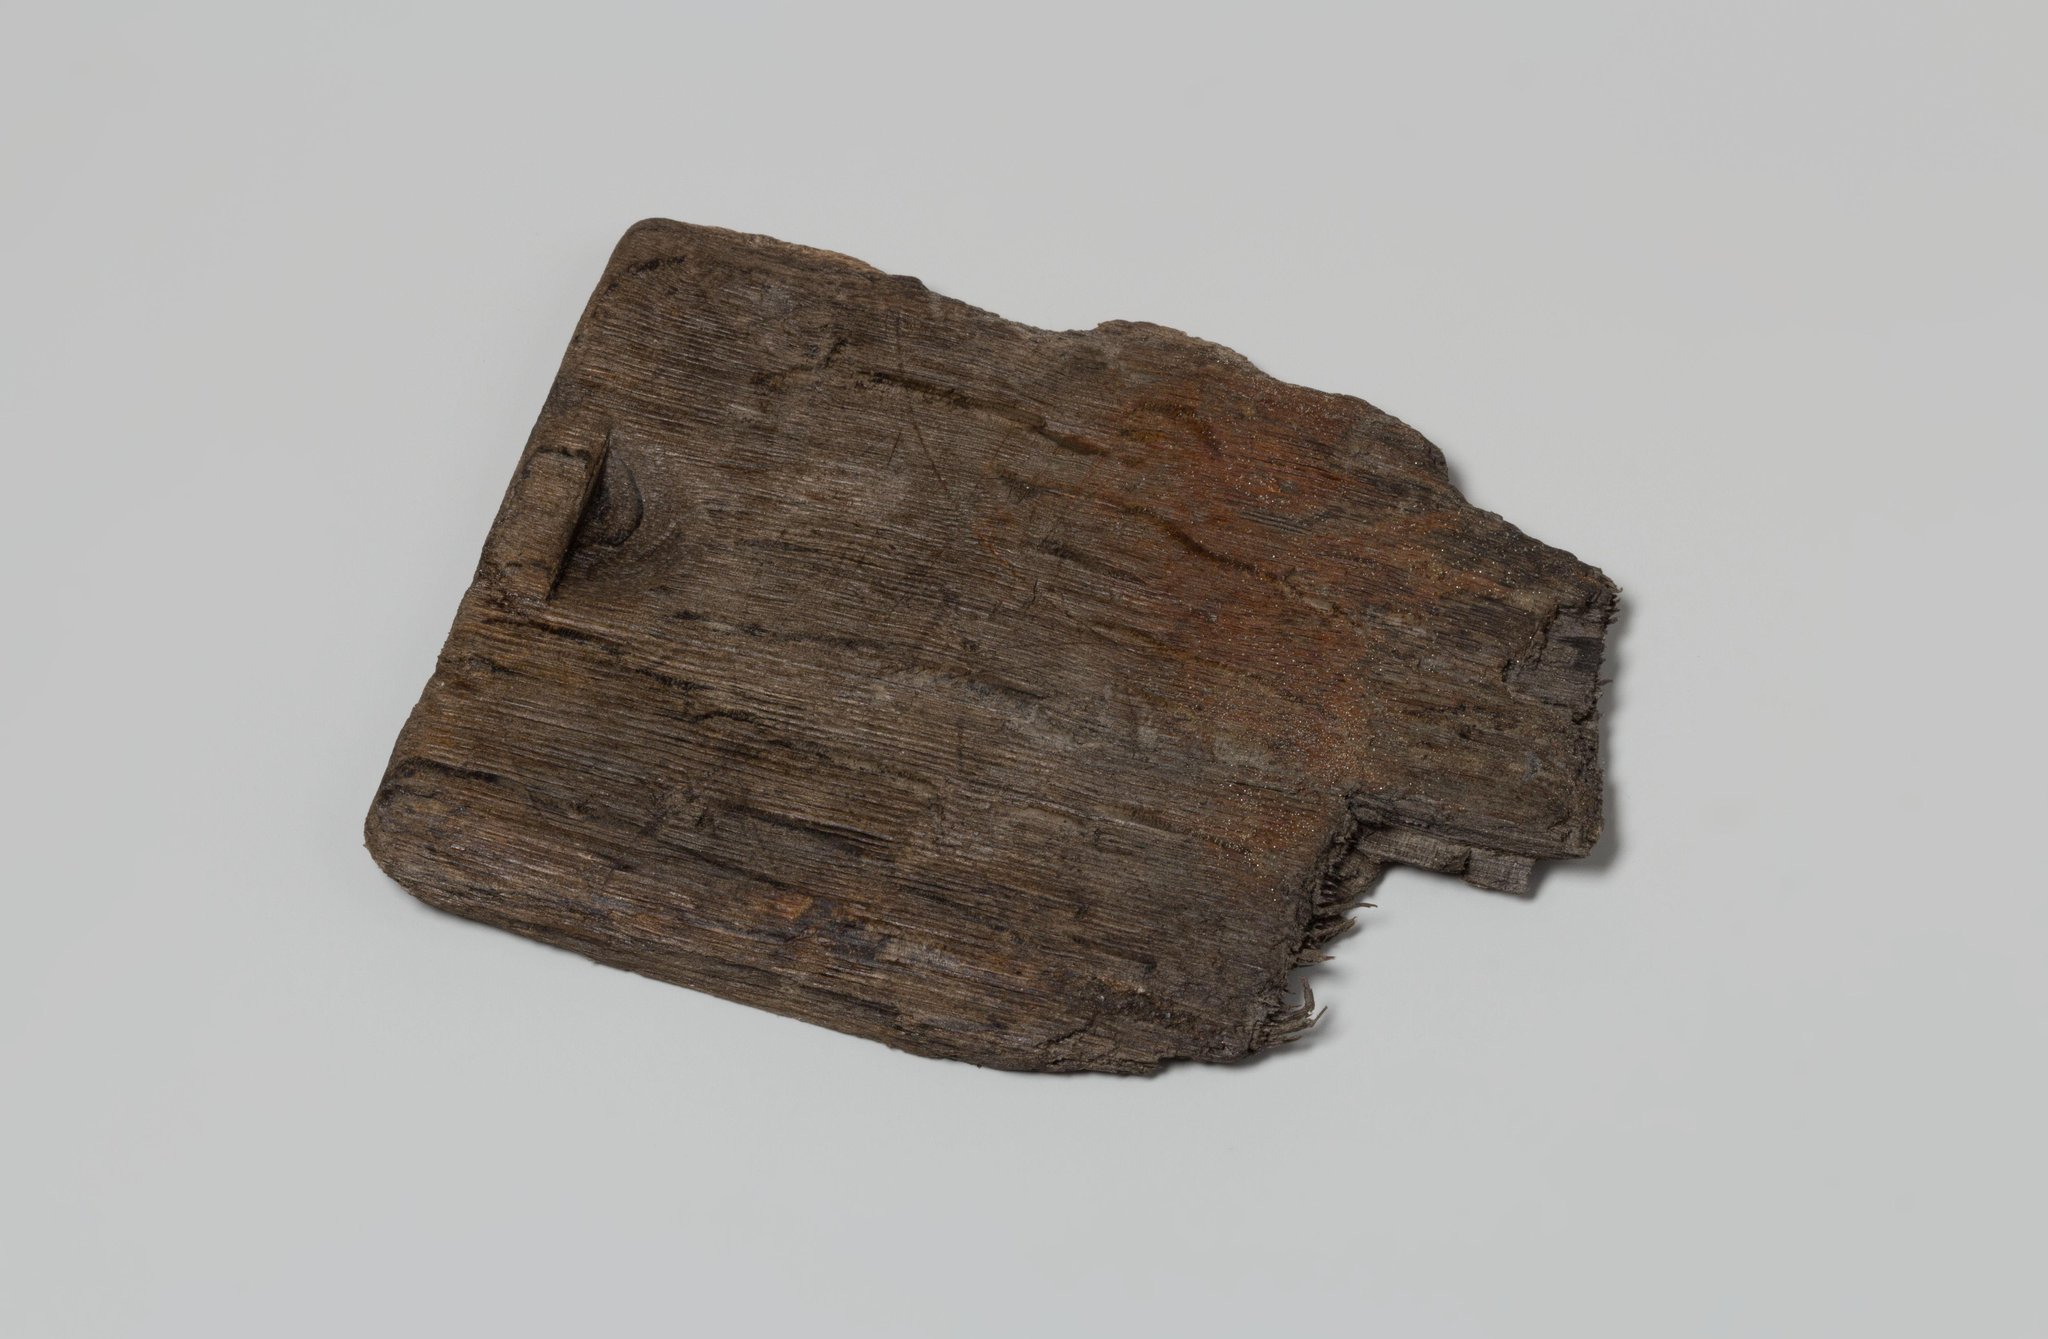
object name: schuifdeksel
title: Fragment van een houten schuifdeksel uit het wrak van de in 1735 vergane Oost-Indiëvaarder 't Vliegend Hart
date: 1700-1735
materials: wood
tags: 't vliegend hart (schip), verenigde oostindische compagnie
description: Het schuifdekseltje is vervaardigd van eikenhout. Het is een plat stuk hout, met aan een korte zijde een inkeping waarmee men het dekseltje kon verschuiven, dus openen. De kleur is donkerbruin/zwart (zie afmetingen).